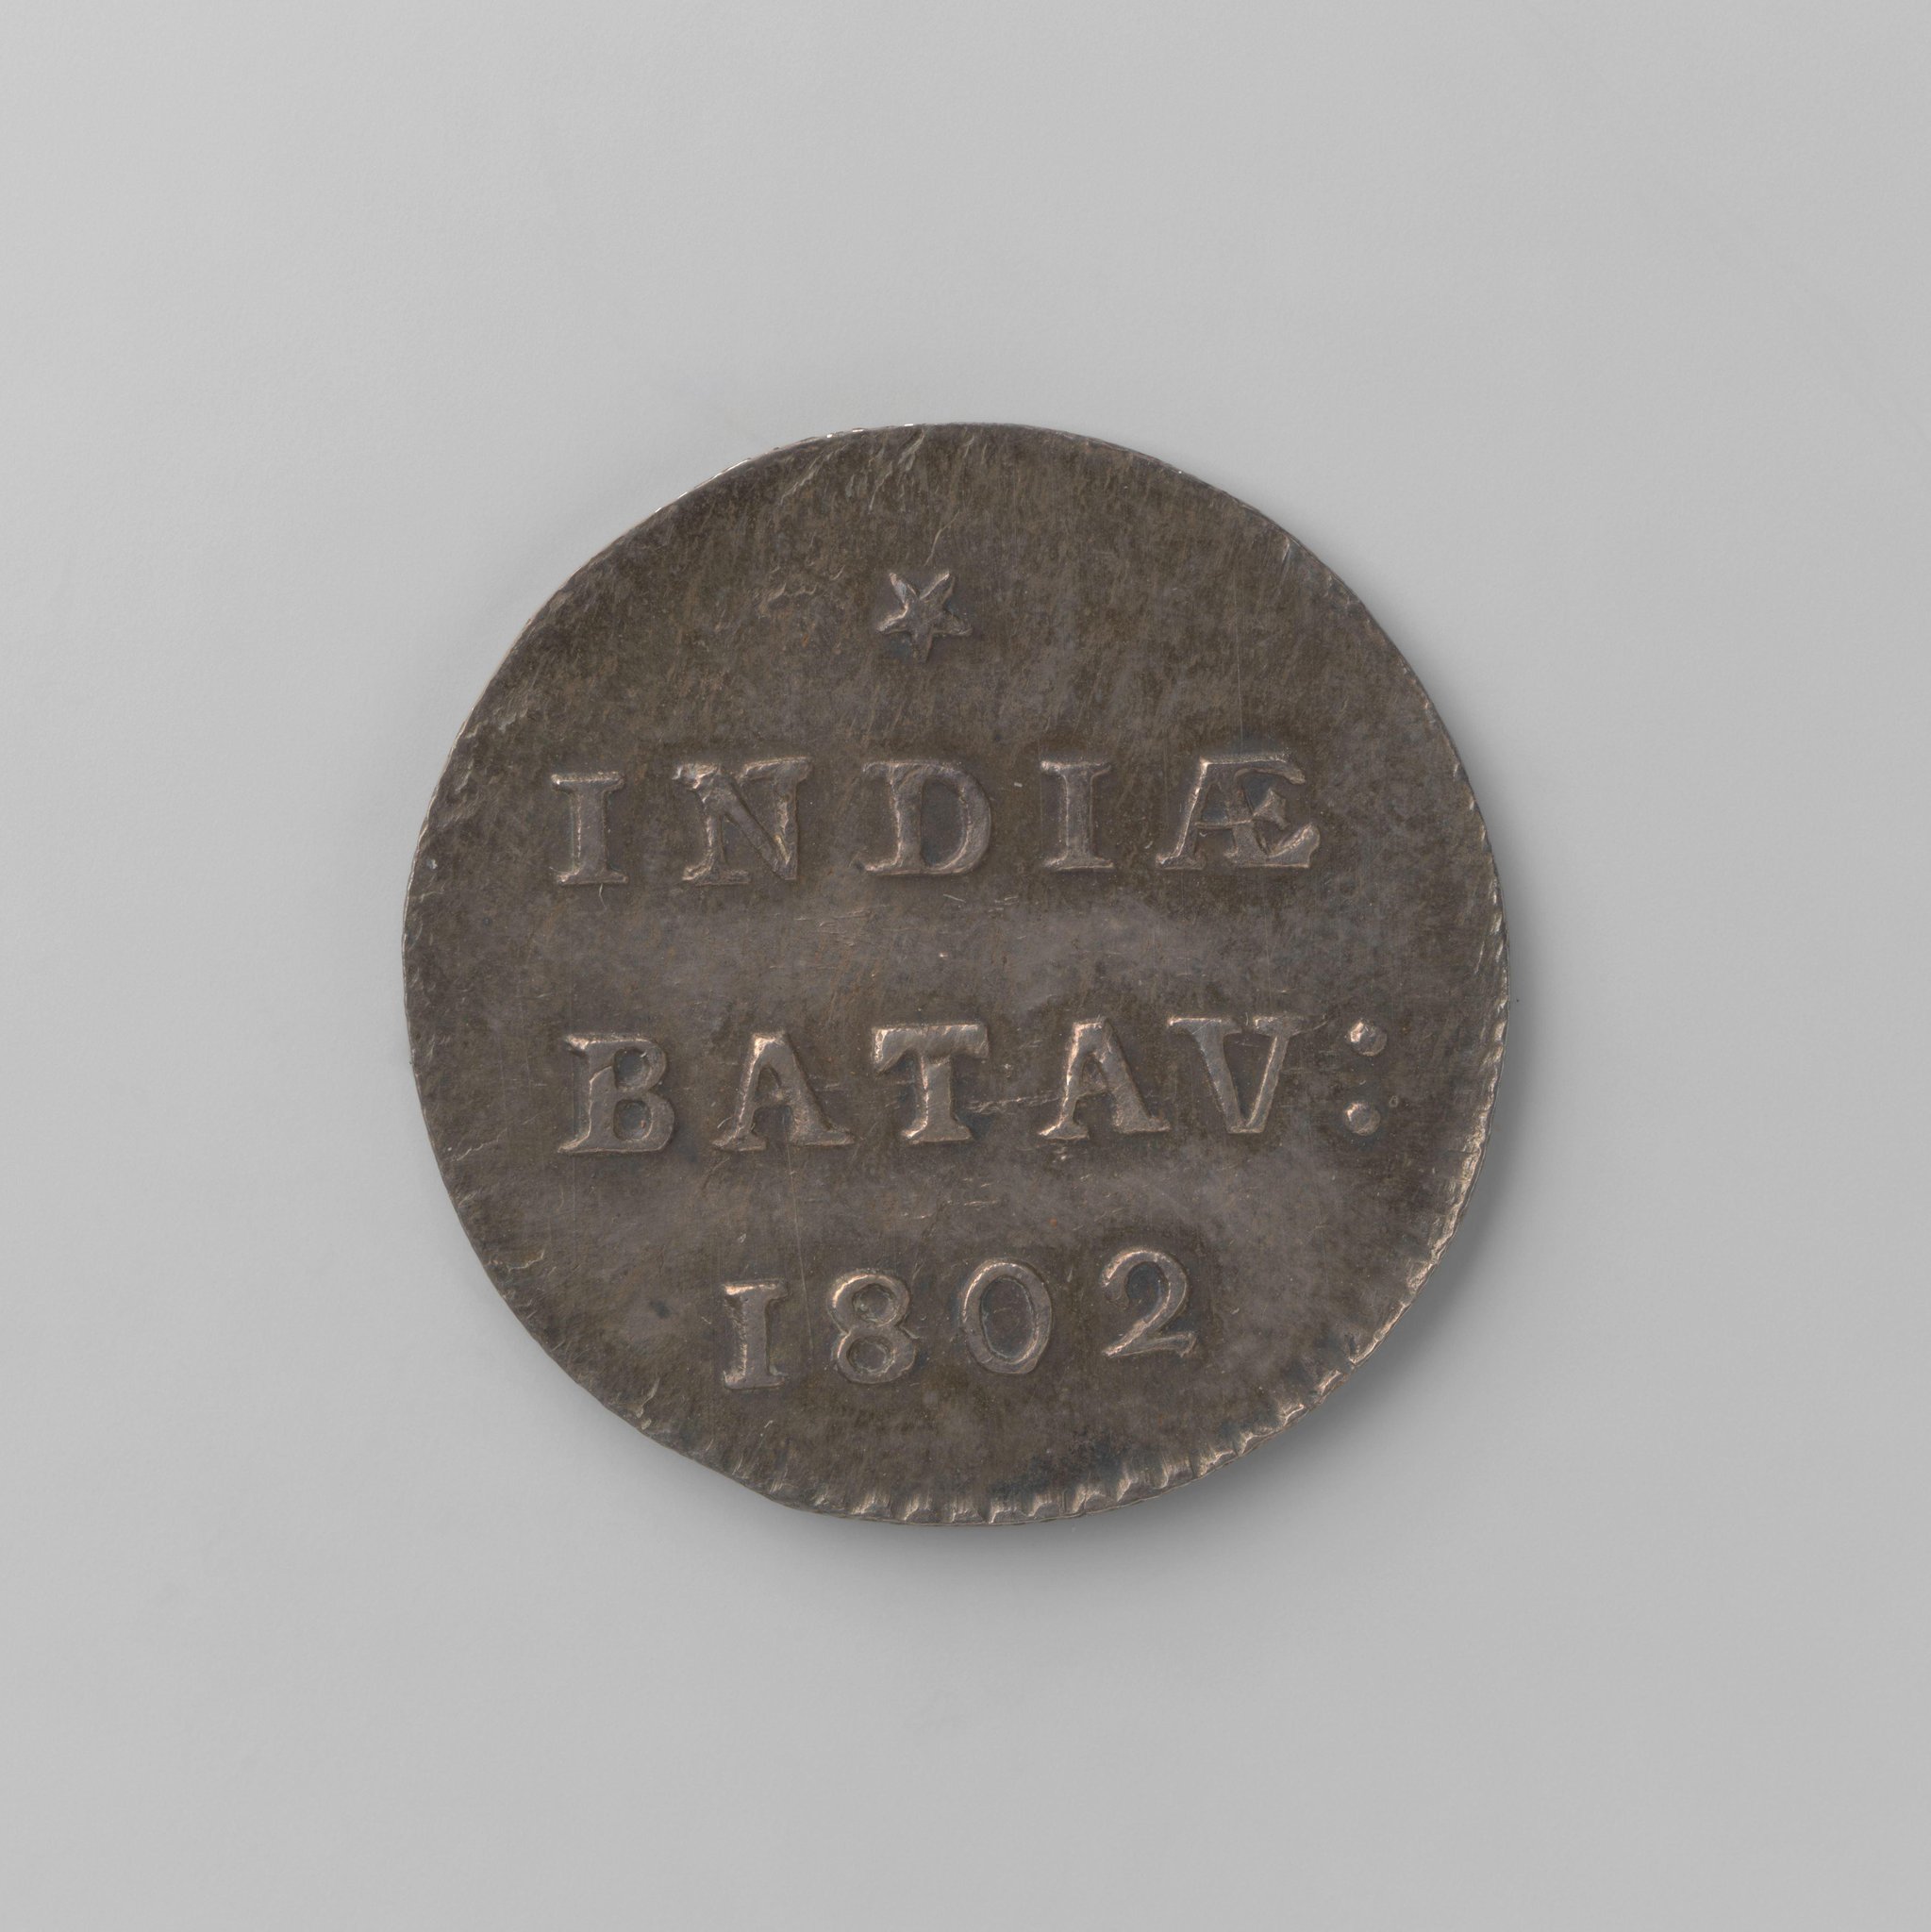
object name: coin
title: Nederlands Indië, duit Holland,1802. Afslag in zilver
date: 1802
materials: silver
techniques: striking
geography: enkhuizen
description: Zilveren munt. Voorzijde: tweeregelig opschrift, waarboven muntteken en waaronder jaartal. Keerzijde: tussen waarde-aanduiding 5 1/16 G gekroond generaliteitswapenschild. Kabelrand.